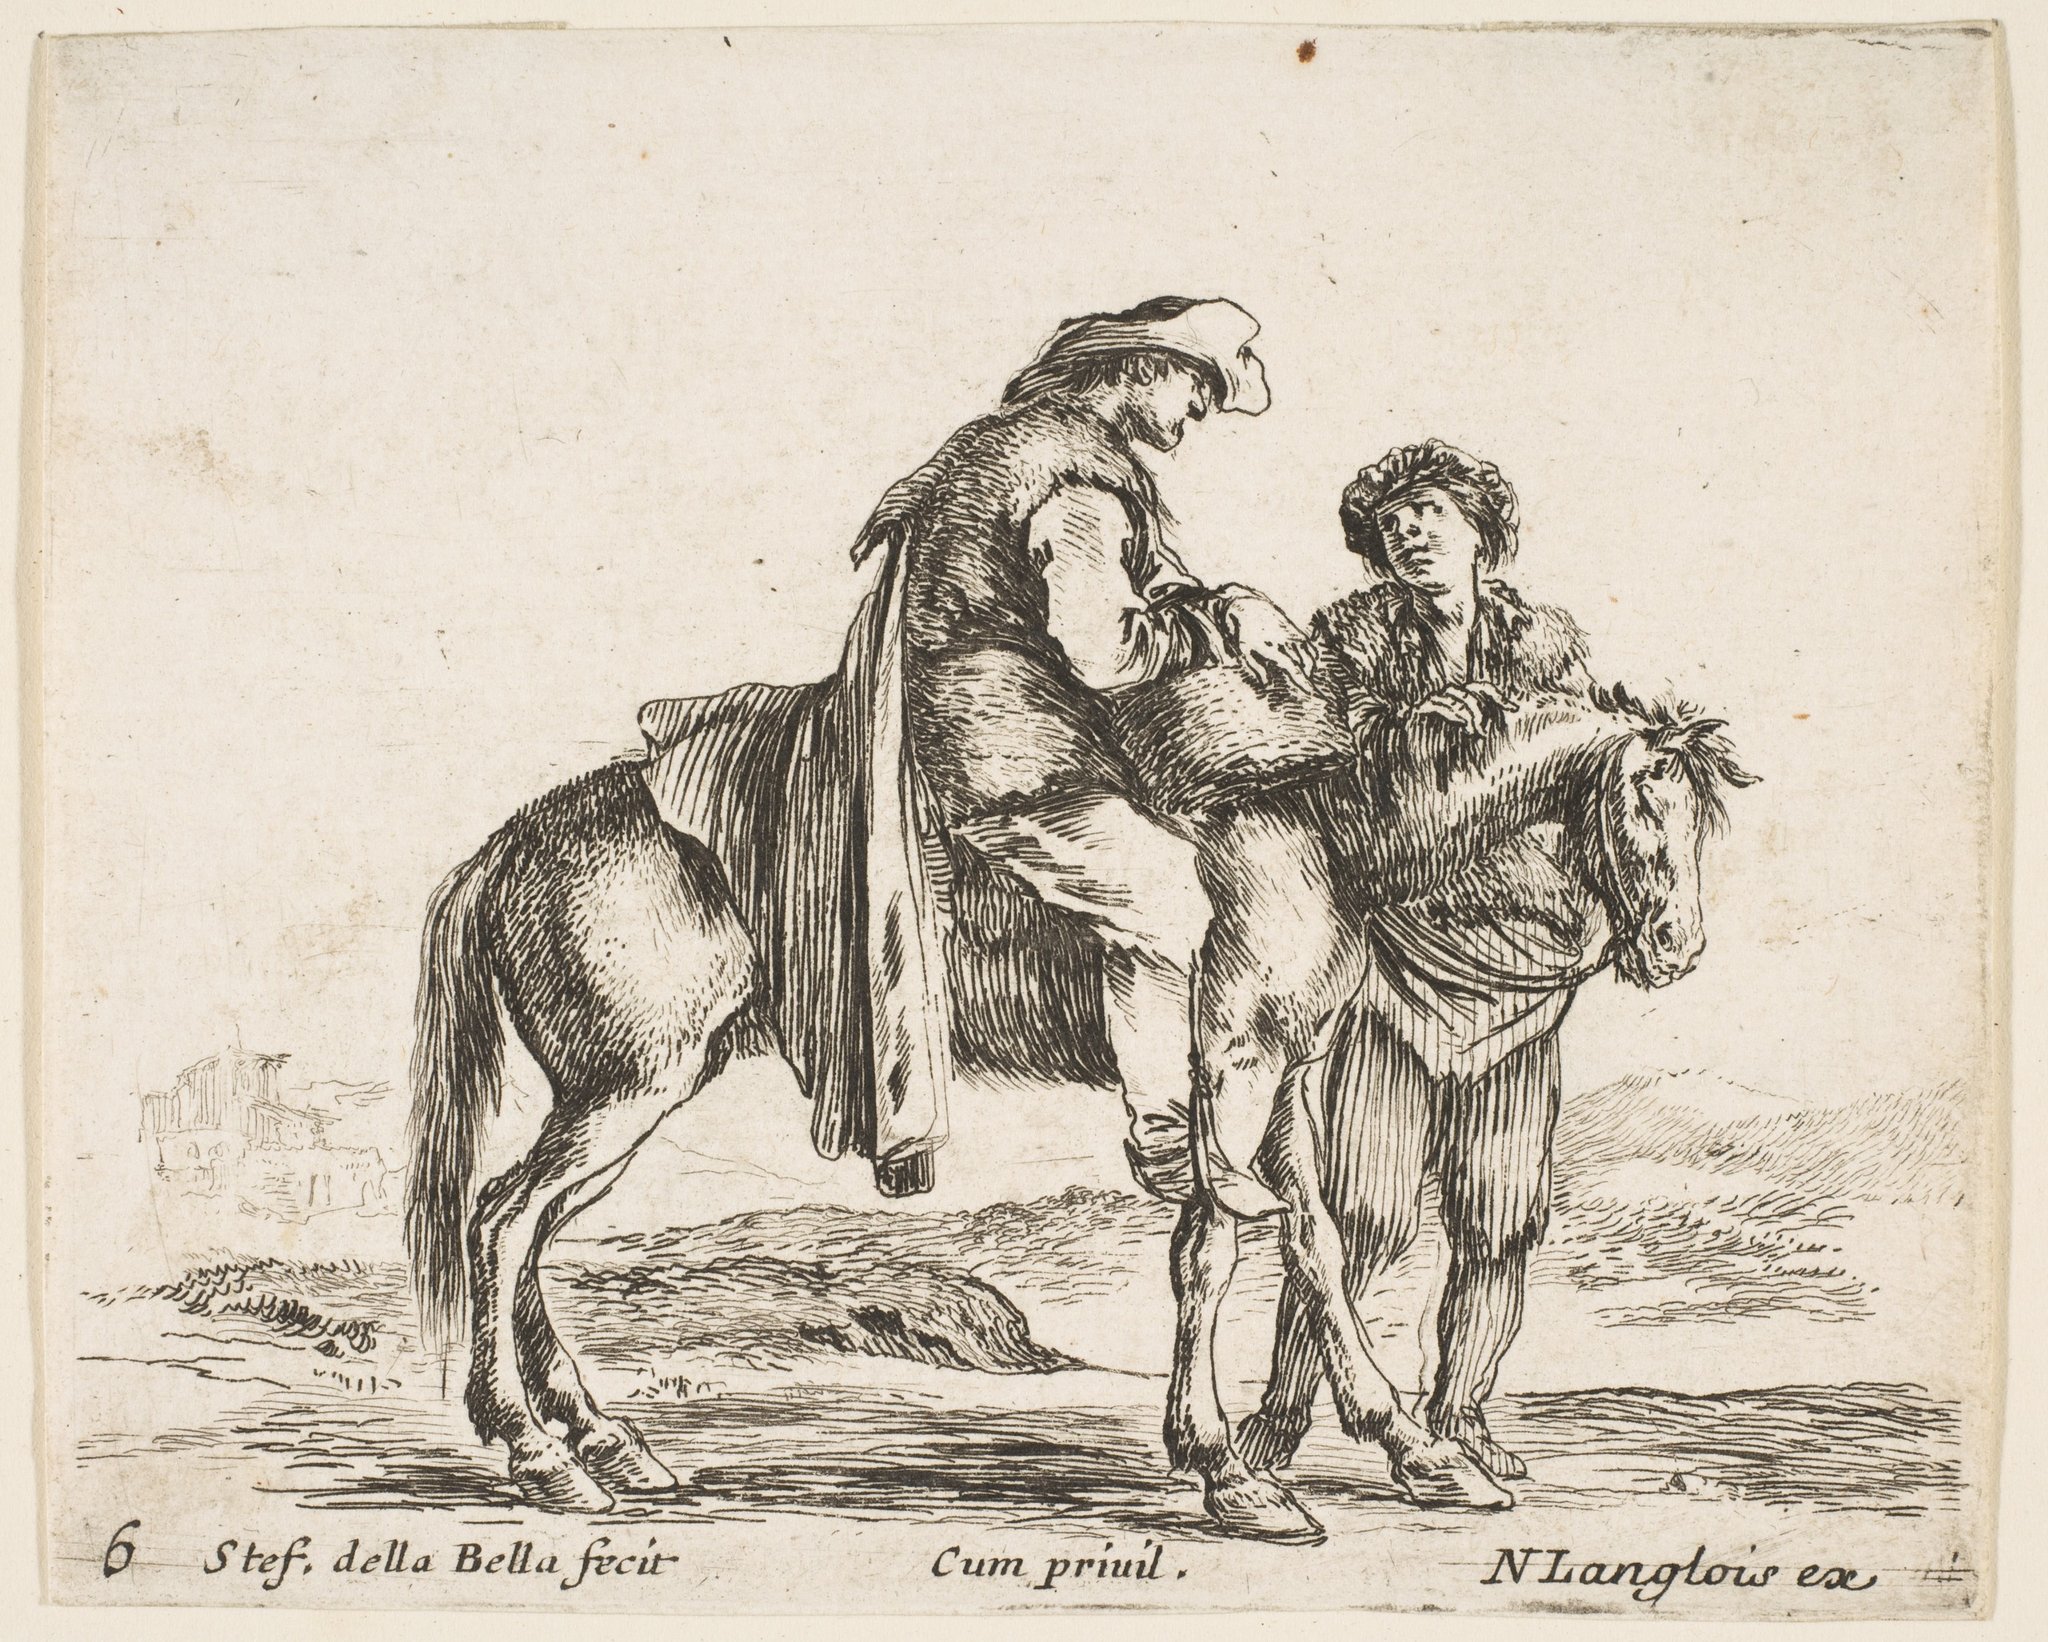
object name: print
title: A peasant on horseback in profile facing the right, holding a basket and talking to another man standing behind the horse, plate 6 from "Diversi capricci"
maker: stefano della bella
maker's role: artist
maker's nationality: italian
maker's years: 1610-1664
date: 1644-1647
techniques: etching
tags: men,horses,farmers